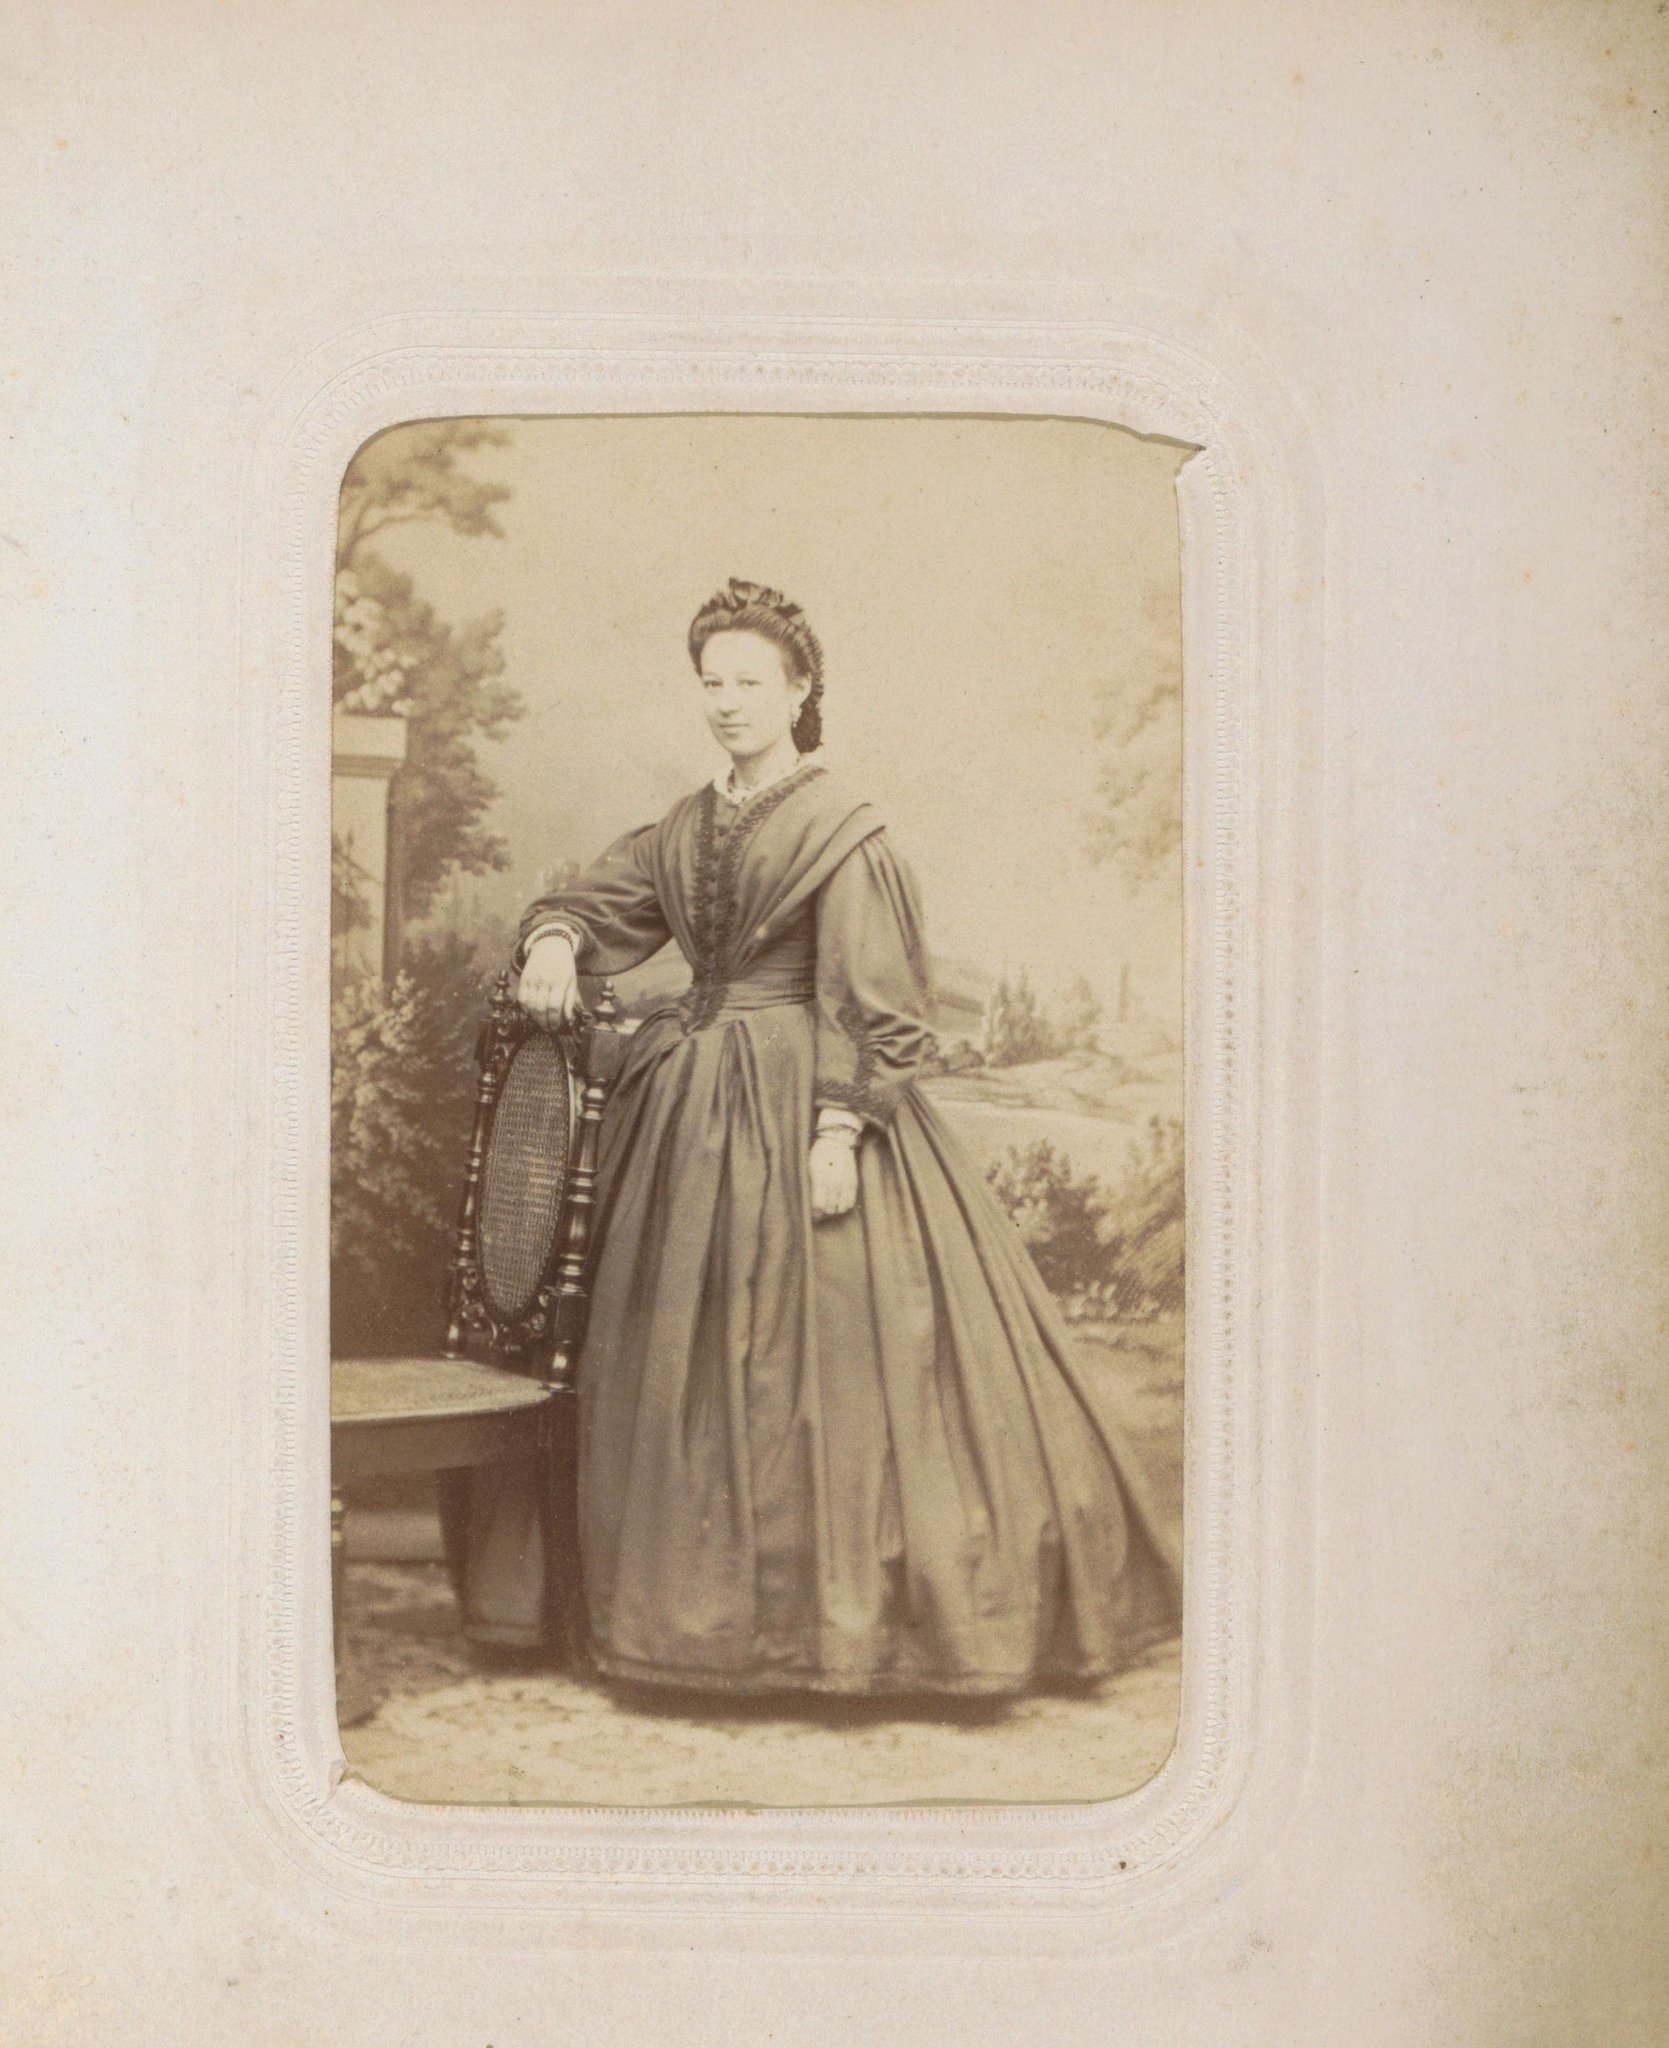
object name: photograph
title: Portret van een vrouw in een lange jurk, staand voor een landschapsdecor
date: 1854-1865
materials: cardboard, paper, photographic support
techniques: albumen print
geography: maastricht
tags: studio requisites ~ photographer, dress, gown, maastricht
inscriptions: address: ‘Maastricht’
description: Onderdeel van Fotoalbum met 26 cartes-de-visite van rooms-katholieke geestelijken.